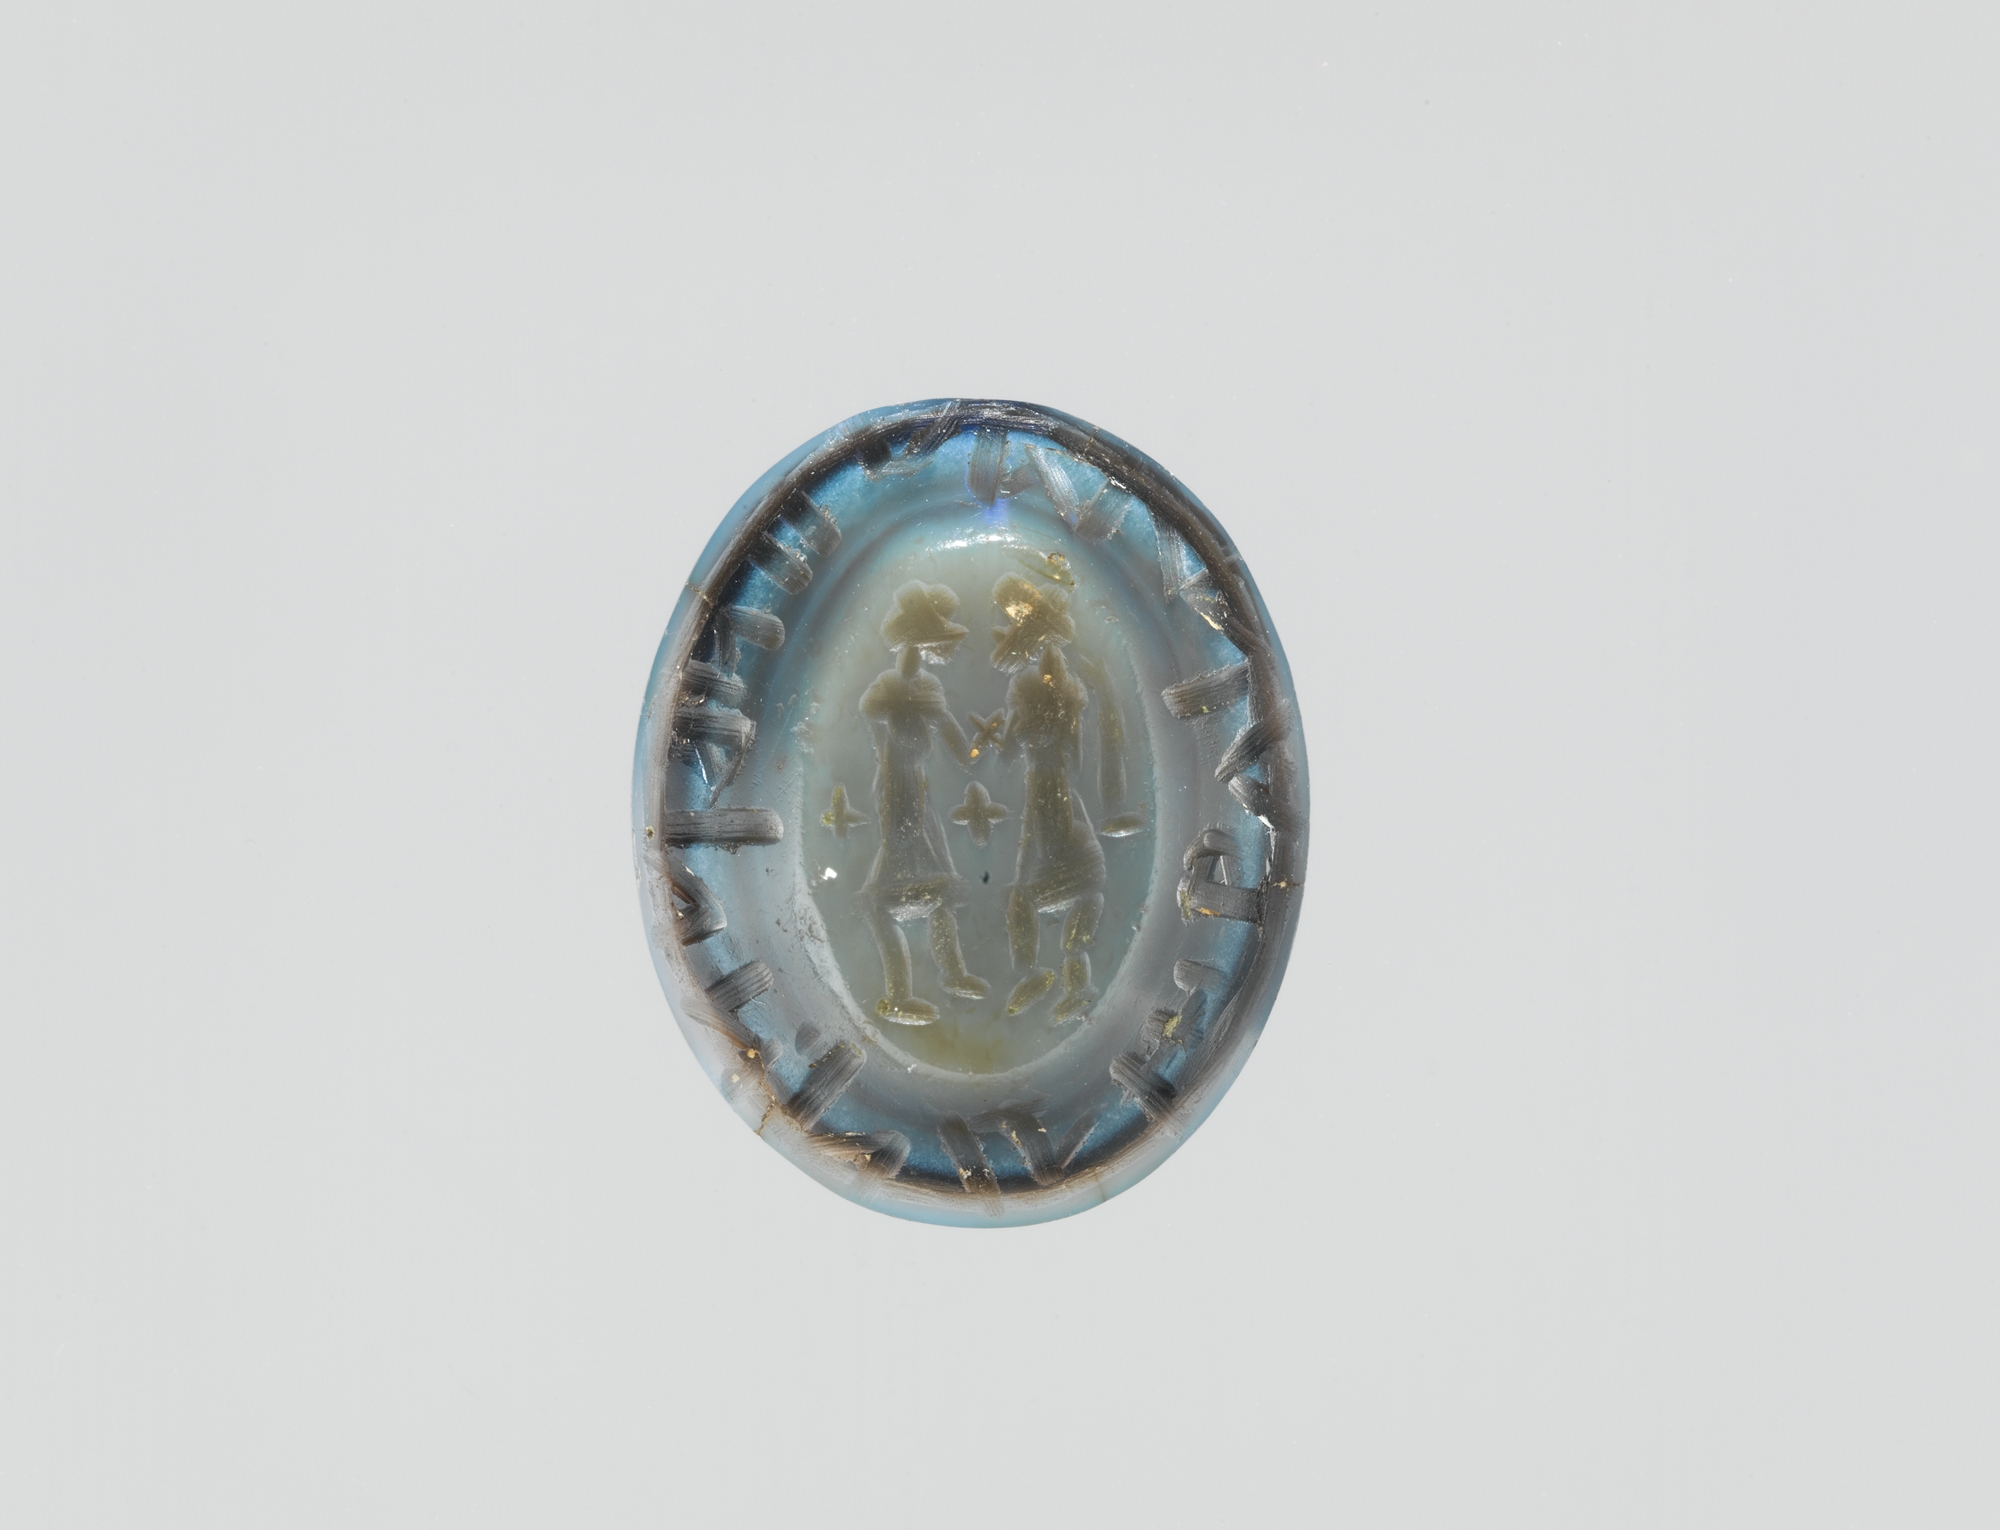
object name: intaglio, magical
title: Nicolo intaglio: Two standing figures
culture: roman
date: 101-300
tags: human figures